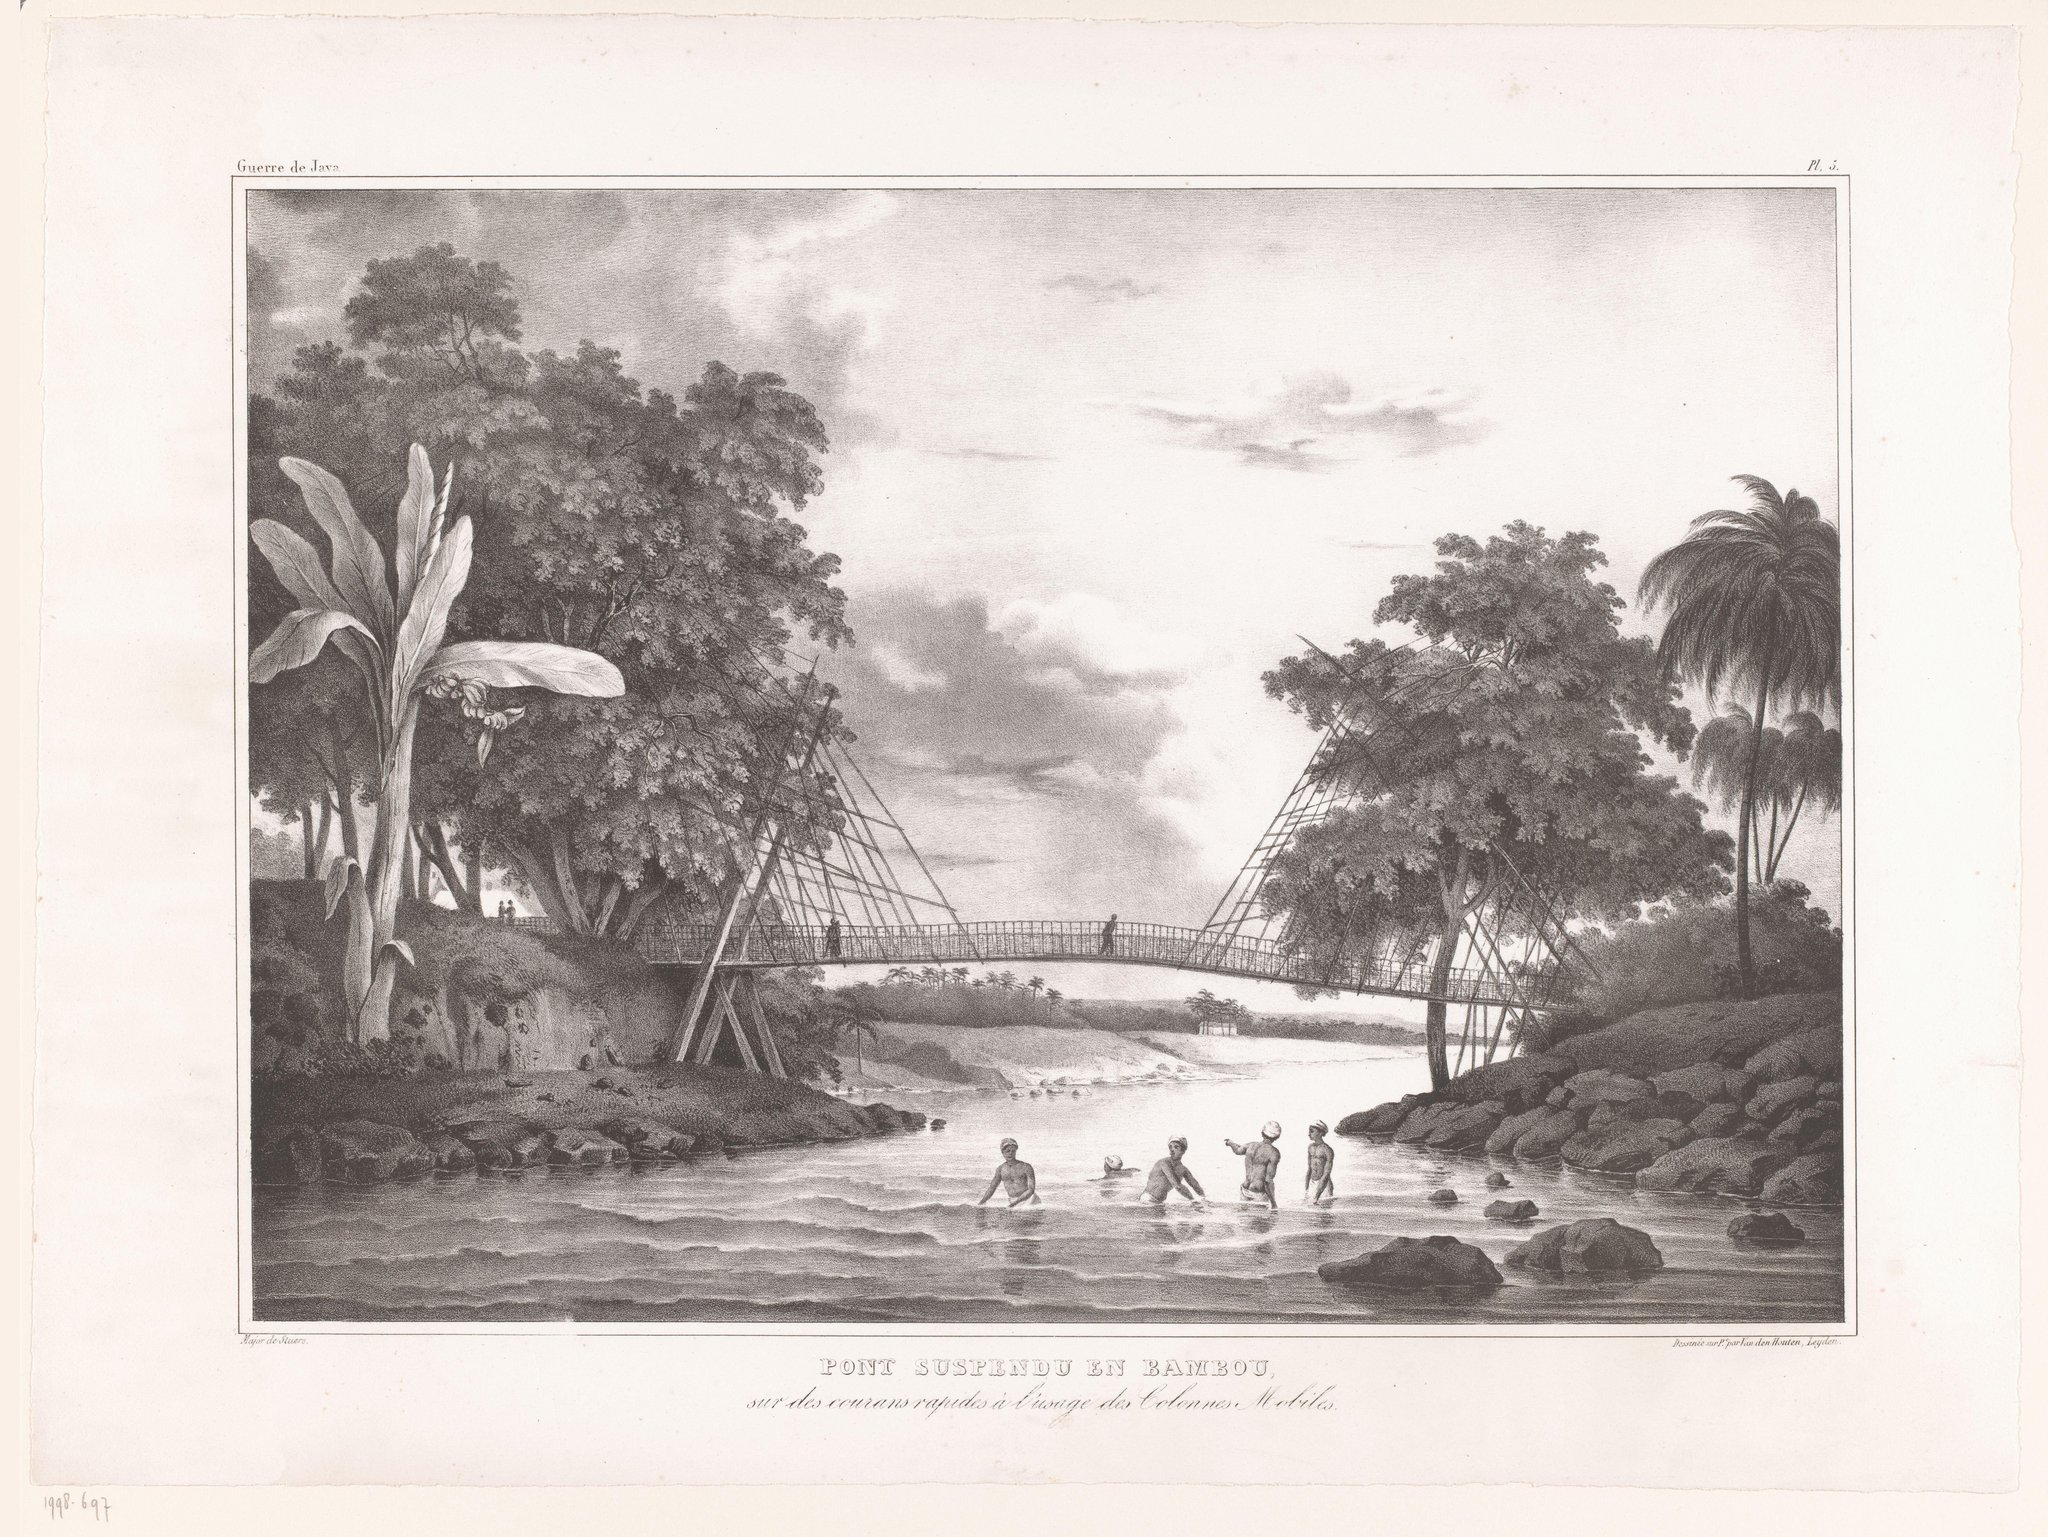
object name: print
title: Geleerde met jongen in interieur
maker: pieter schenk (i)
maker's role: print maker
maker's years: 1660-1711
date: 1702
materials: paper, watercolor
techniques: etching, hand coloring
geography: amsterdam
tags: chinese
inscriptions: collector's mark: Lugt 2228, collector's mark: Lugt 2760